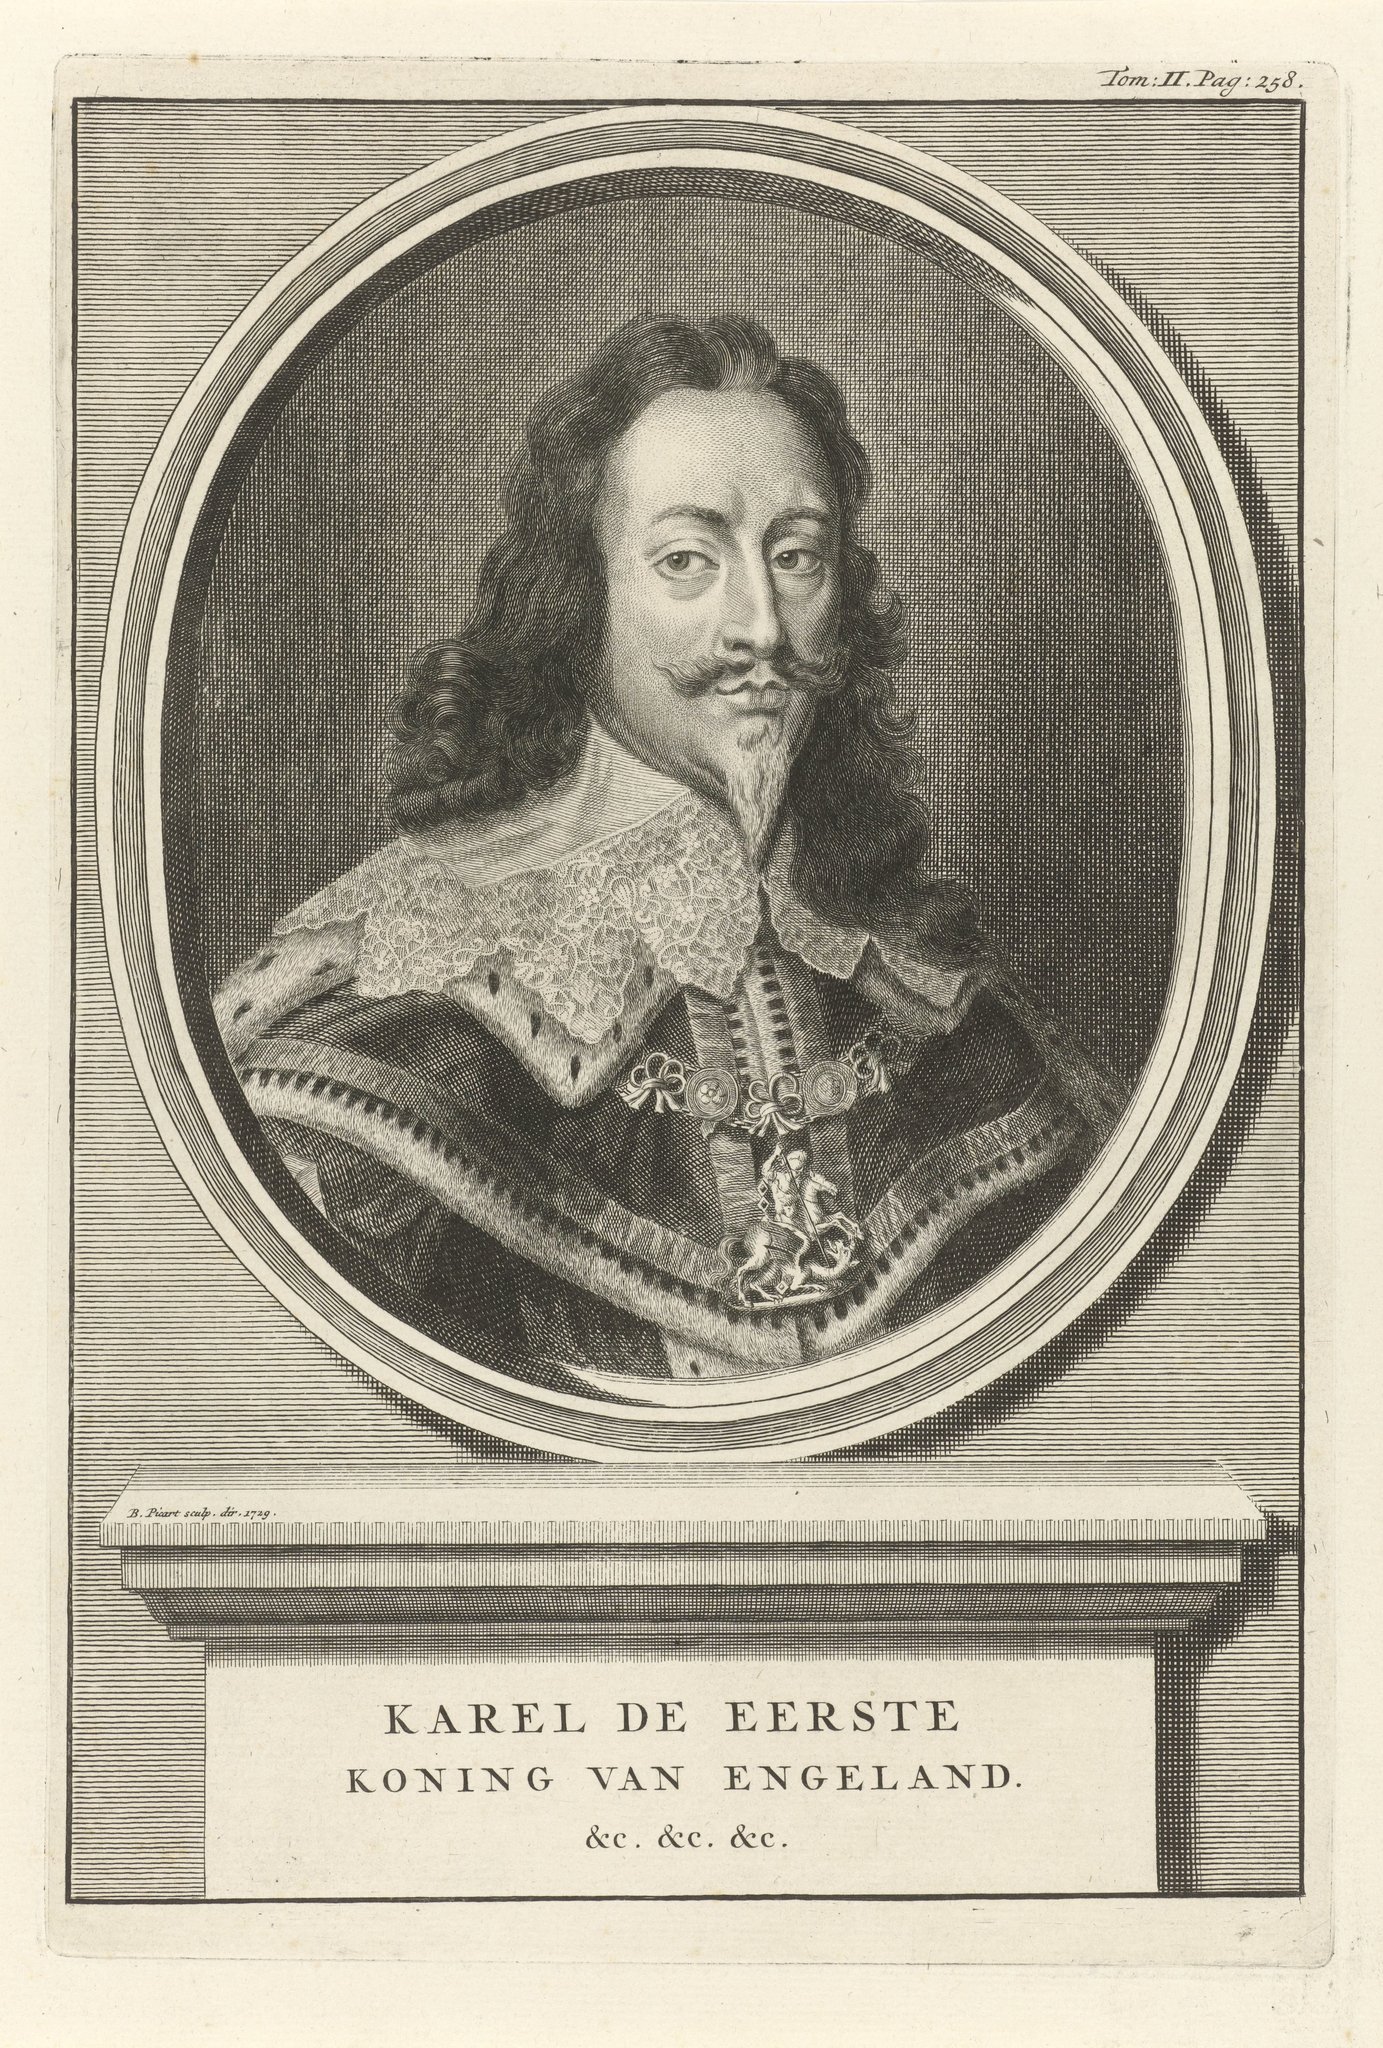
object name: print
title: Busteportret van Karel I van Engeland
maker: bernard picart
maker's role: draughtsman, print maker, publisher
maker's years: 1673-1733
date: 1729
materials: paper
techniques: engraving, etching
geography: amsterdam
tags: london, karel i (koning van engeland), knighthood order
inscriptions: collector's mark: Lugt 2228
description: Prent als illustratie gebruikt in: Le Clerc, Jean. Geschiedenissen der Vereenigde Nederlanden. Amsterdam: Zacharias Chatelain (II), 1730.